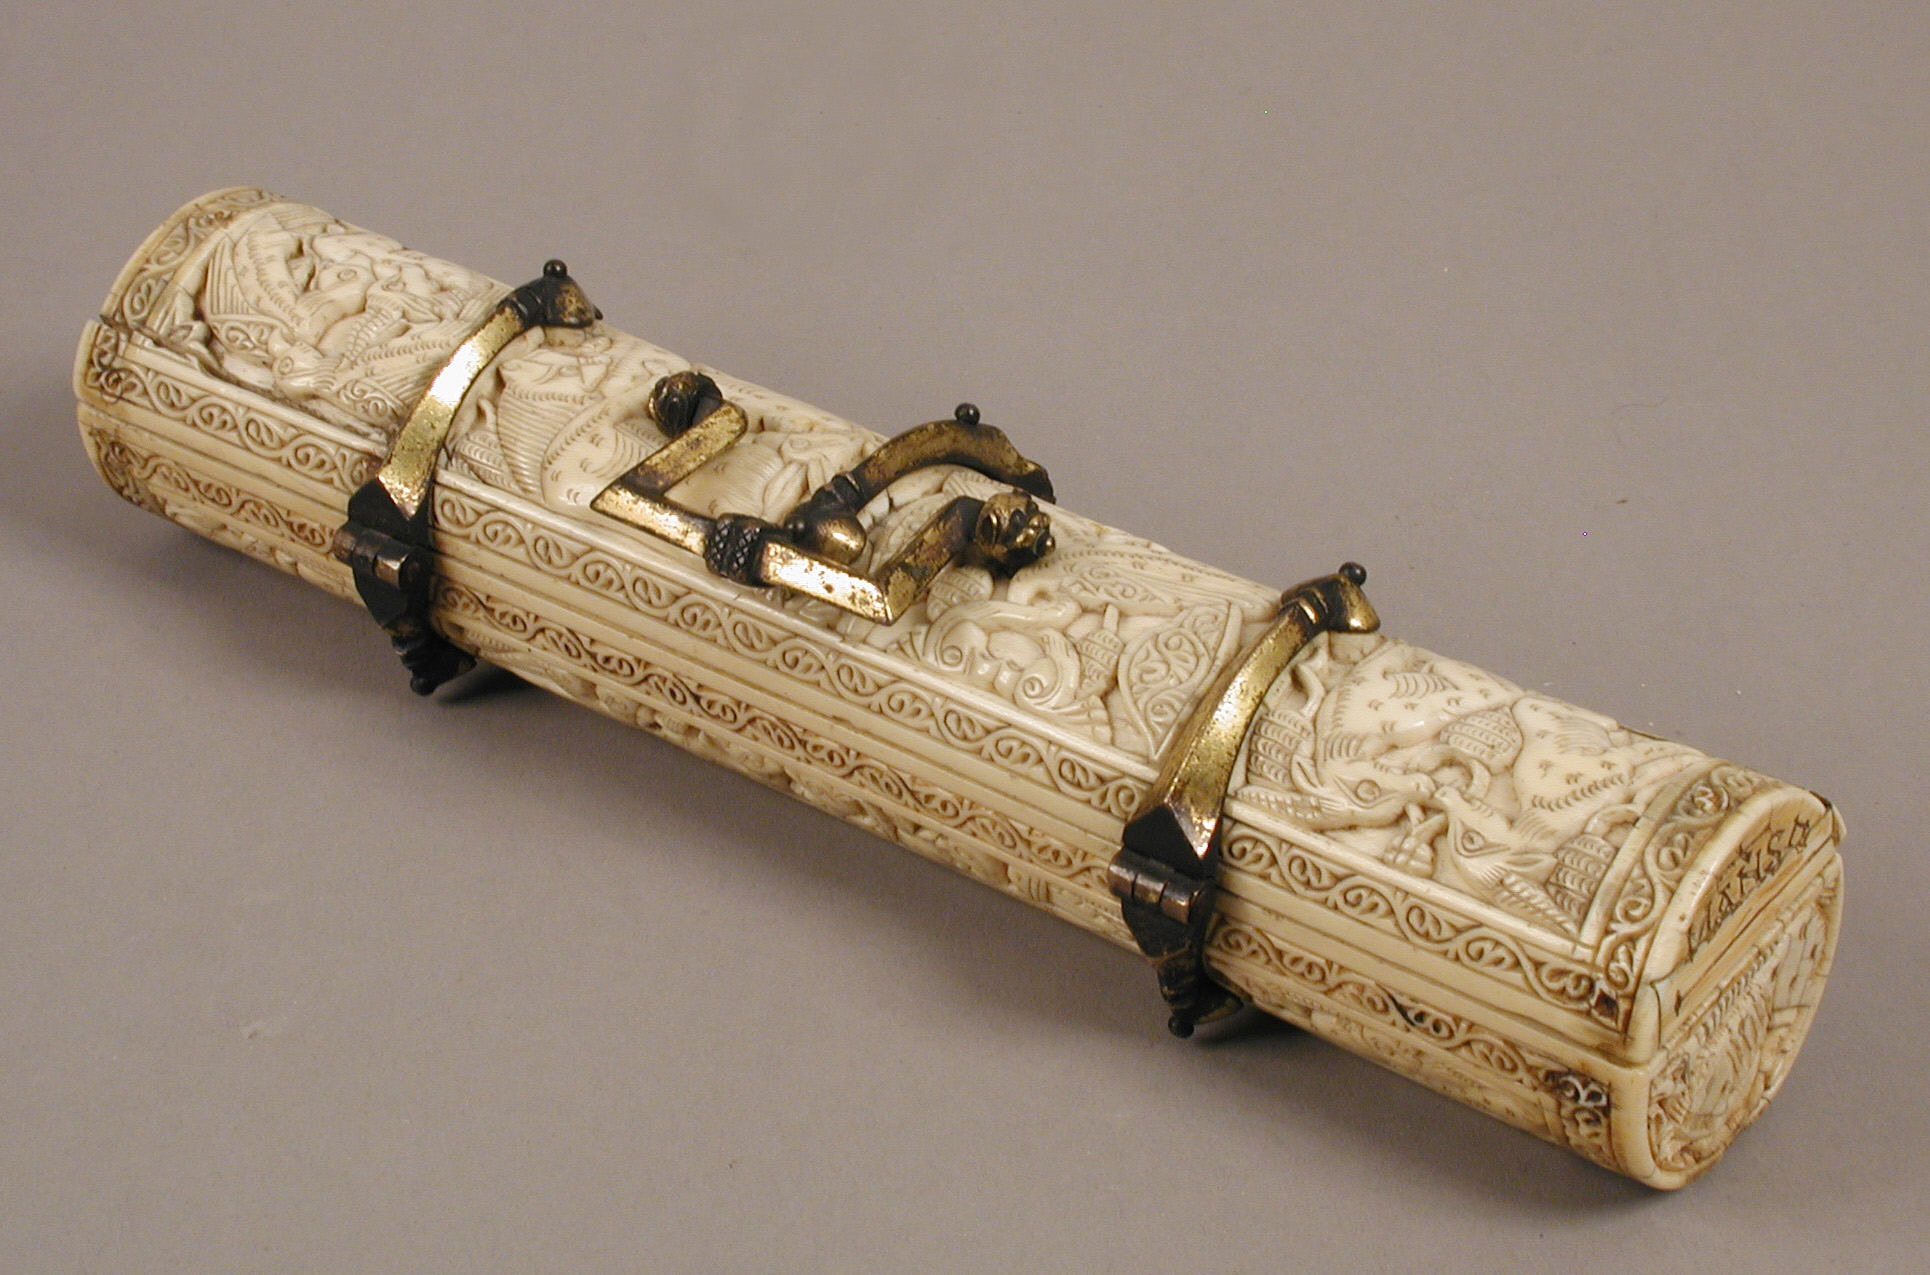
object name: pen box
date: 1067-1133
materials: copper alloy, ivory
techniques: carving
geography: italy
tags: animals,birds